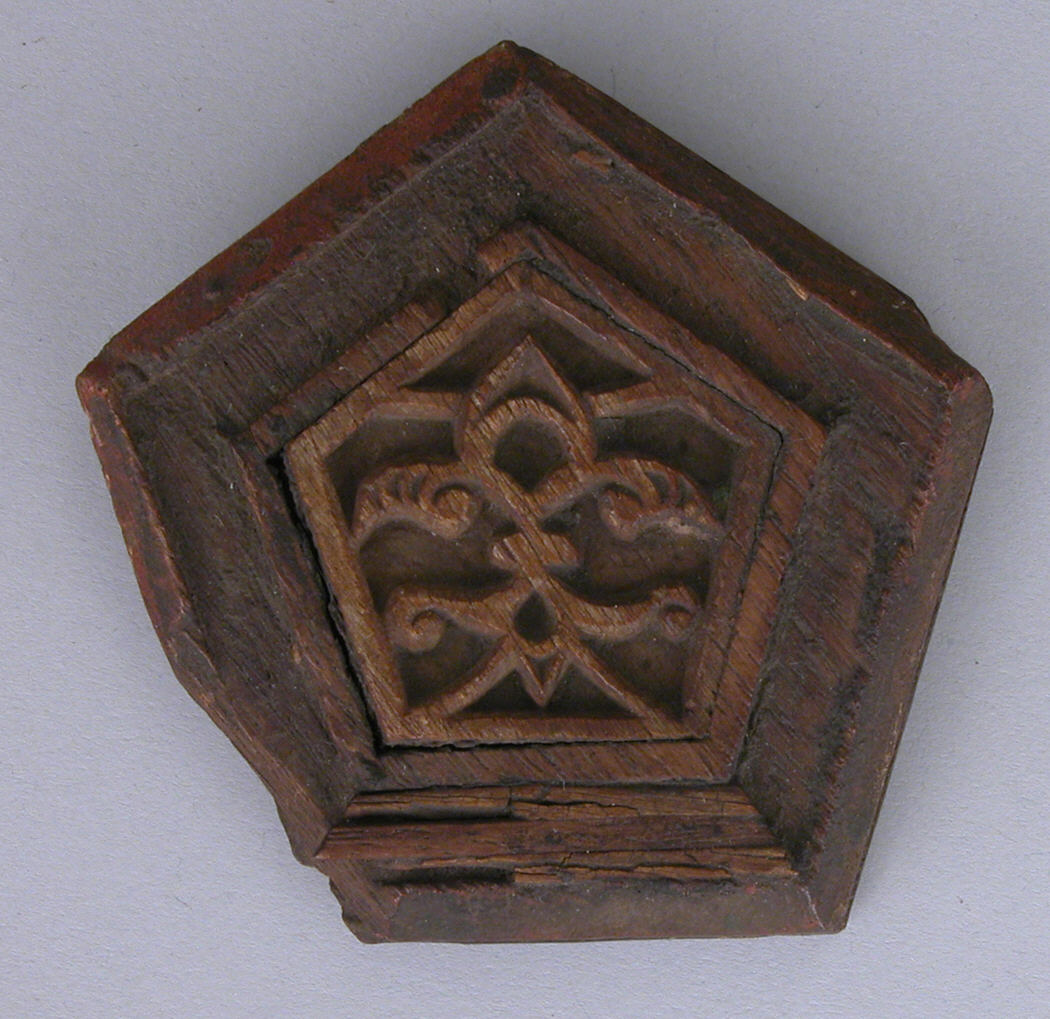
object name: panel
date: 1301-1500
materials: wood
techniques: carving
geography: egypt